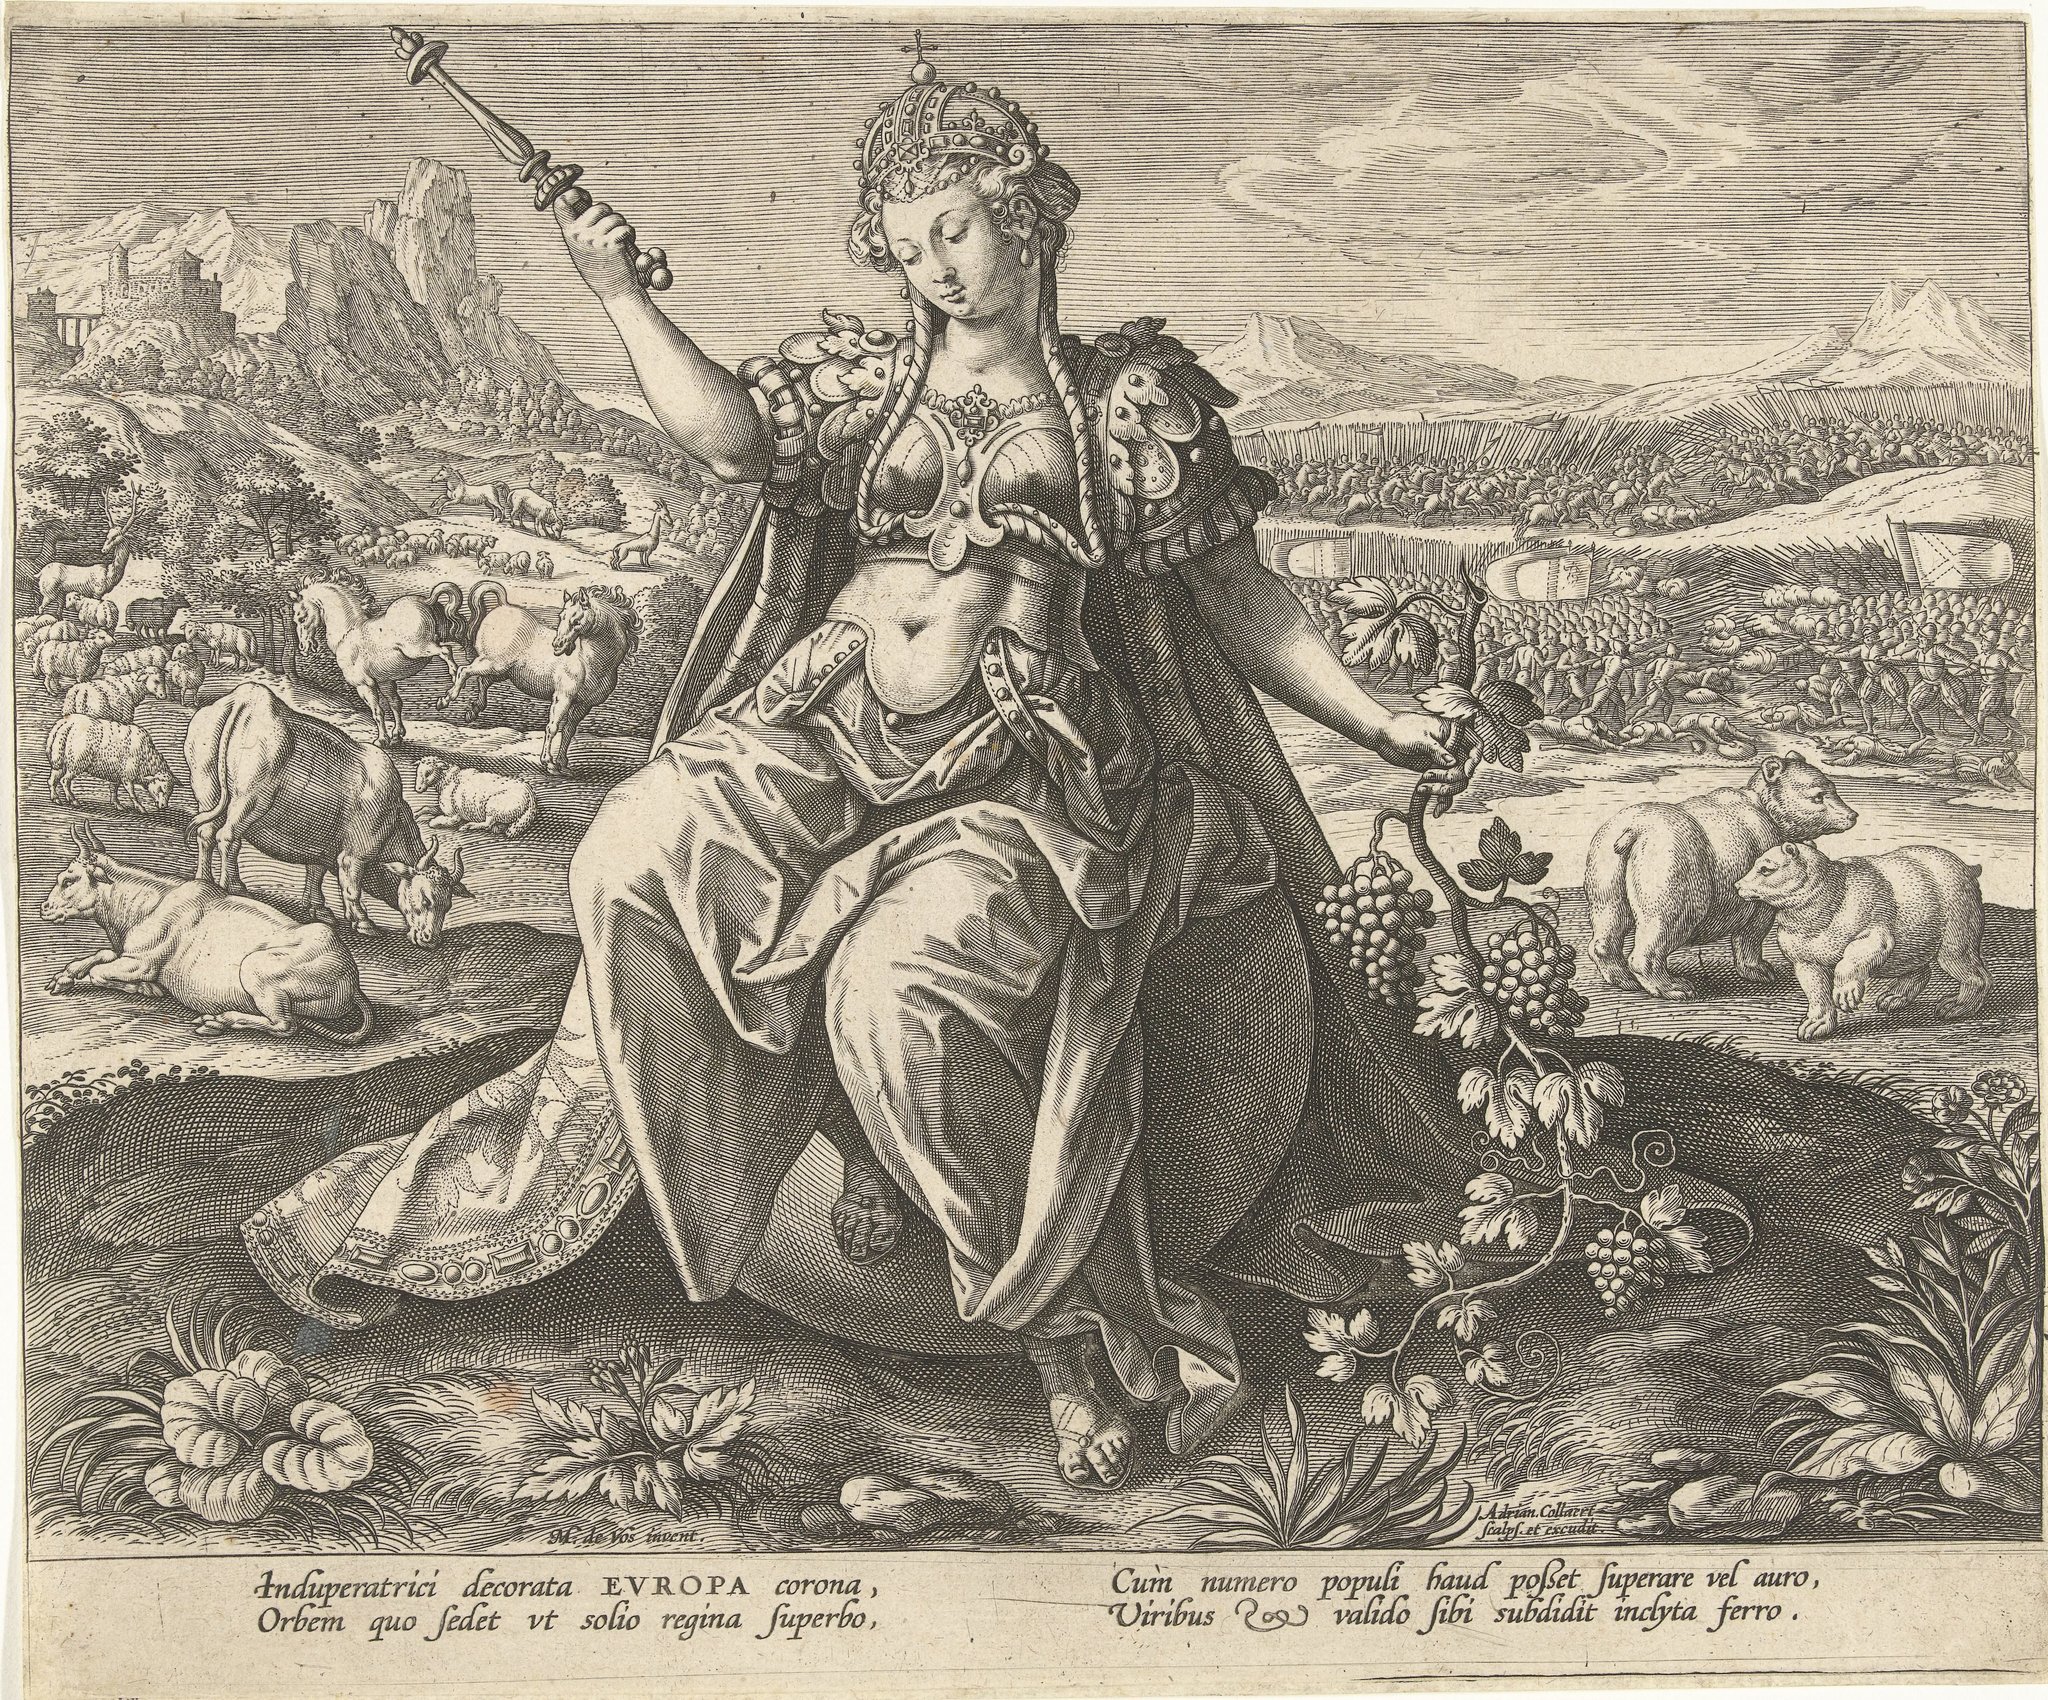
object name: print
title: Europa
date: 1586-1591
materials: paper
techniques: engraving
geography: antwerp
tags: cow, europe represented allegorically; 'europa' (ripa), battle, beasts of prey, predatory animals: bear, sheep, horse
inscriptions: collector's mark: Lugt 2228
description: De vrouwelijke personificatie van het continent Europa zit op een wereldbol. In haar handen een scepter en een wijnrank. Op haar hoofd draagt zij als koningin van de wereld een kroon. Op de achtergrond dieren zoals koeien, schapen, paarden en beren. Rechtsachter een veldslag. De prent heeft een Latijns onderschrift en is deel van een vierdelige serie met personificaties van de vier continenten.